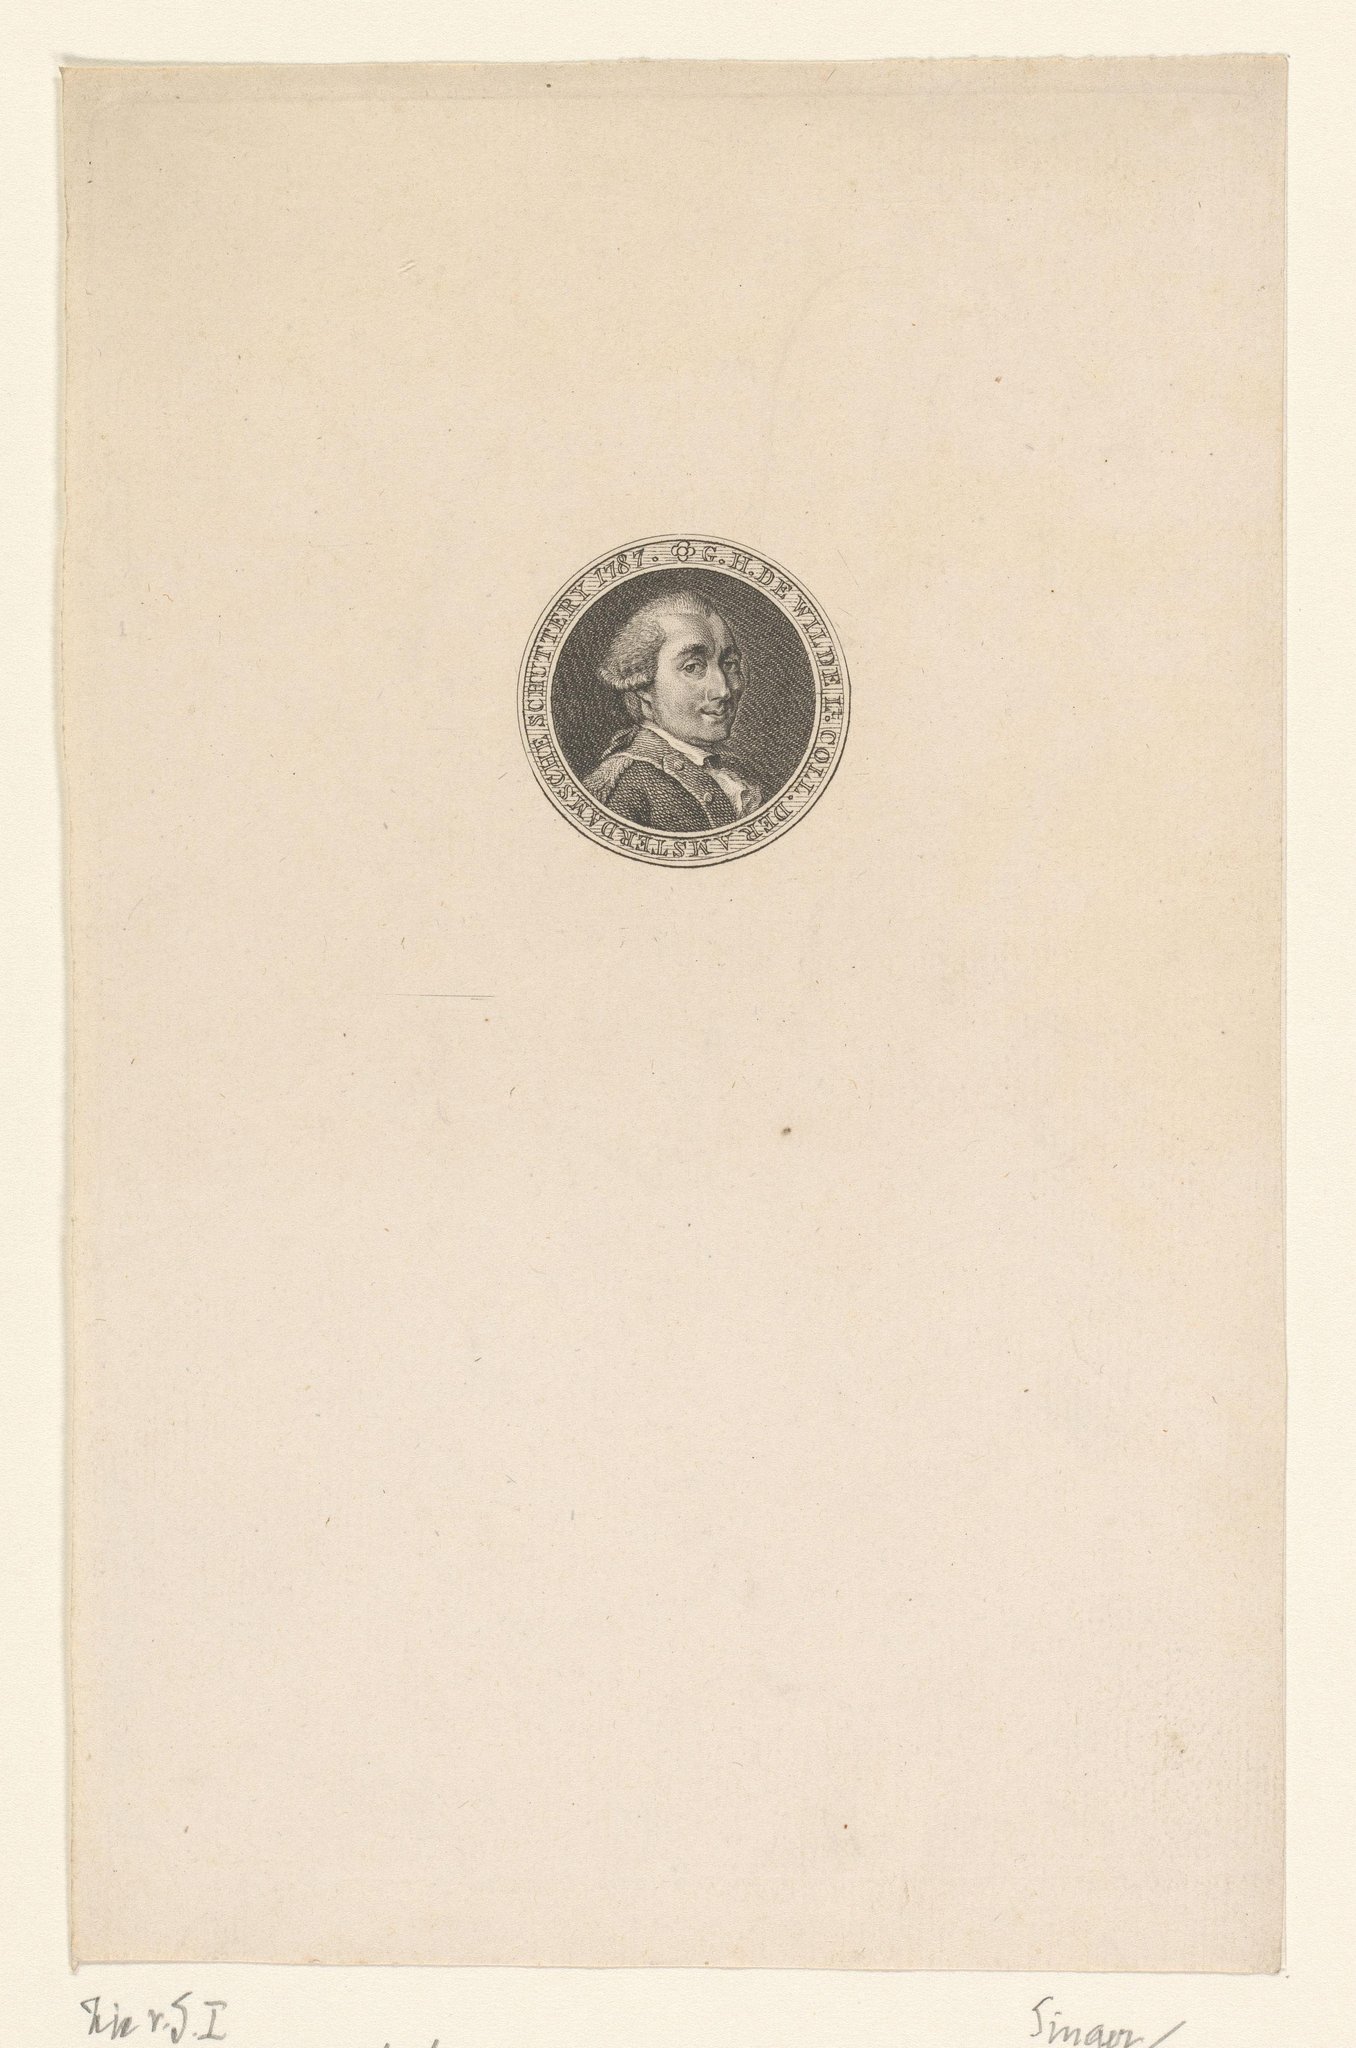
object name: print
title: Portret van George Hendrik de Wilde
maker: abraham jacobsz. hulk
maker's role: print maker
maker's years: 1751-1817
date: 1787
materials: paper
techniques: engraving, etching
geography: paris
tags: historical persons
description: Jacobus Wijsman heeft sommige platen van de serie patriottenportretten van Abraham Jacobsz. Hulk aangepast en hergebruikt in zijn eigen serie patriottenportretten. Prent waarschijnlijk uit: Nomsz, Johannes. Vaderlandsche chocolaad. Amsterdam: Dirk Meland Langeveld, 1796.